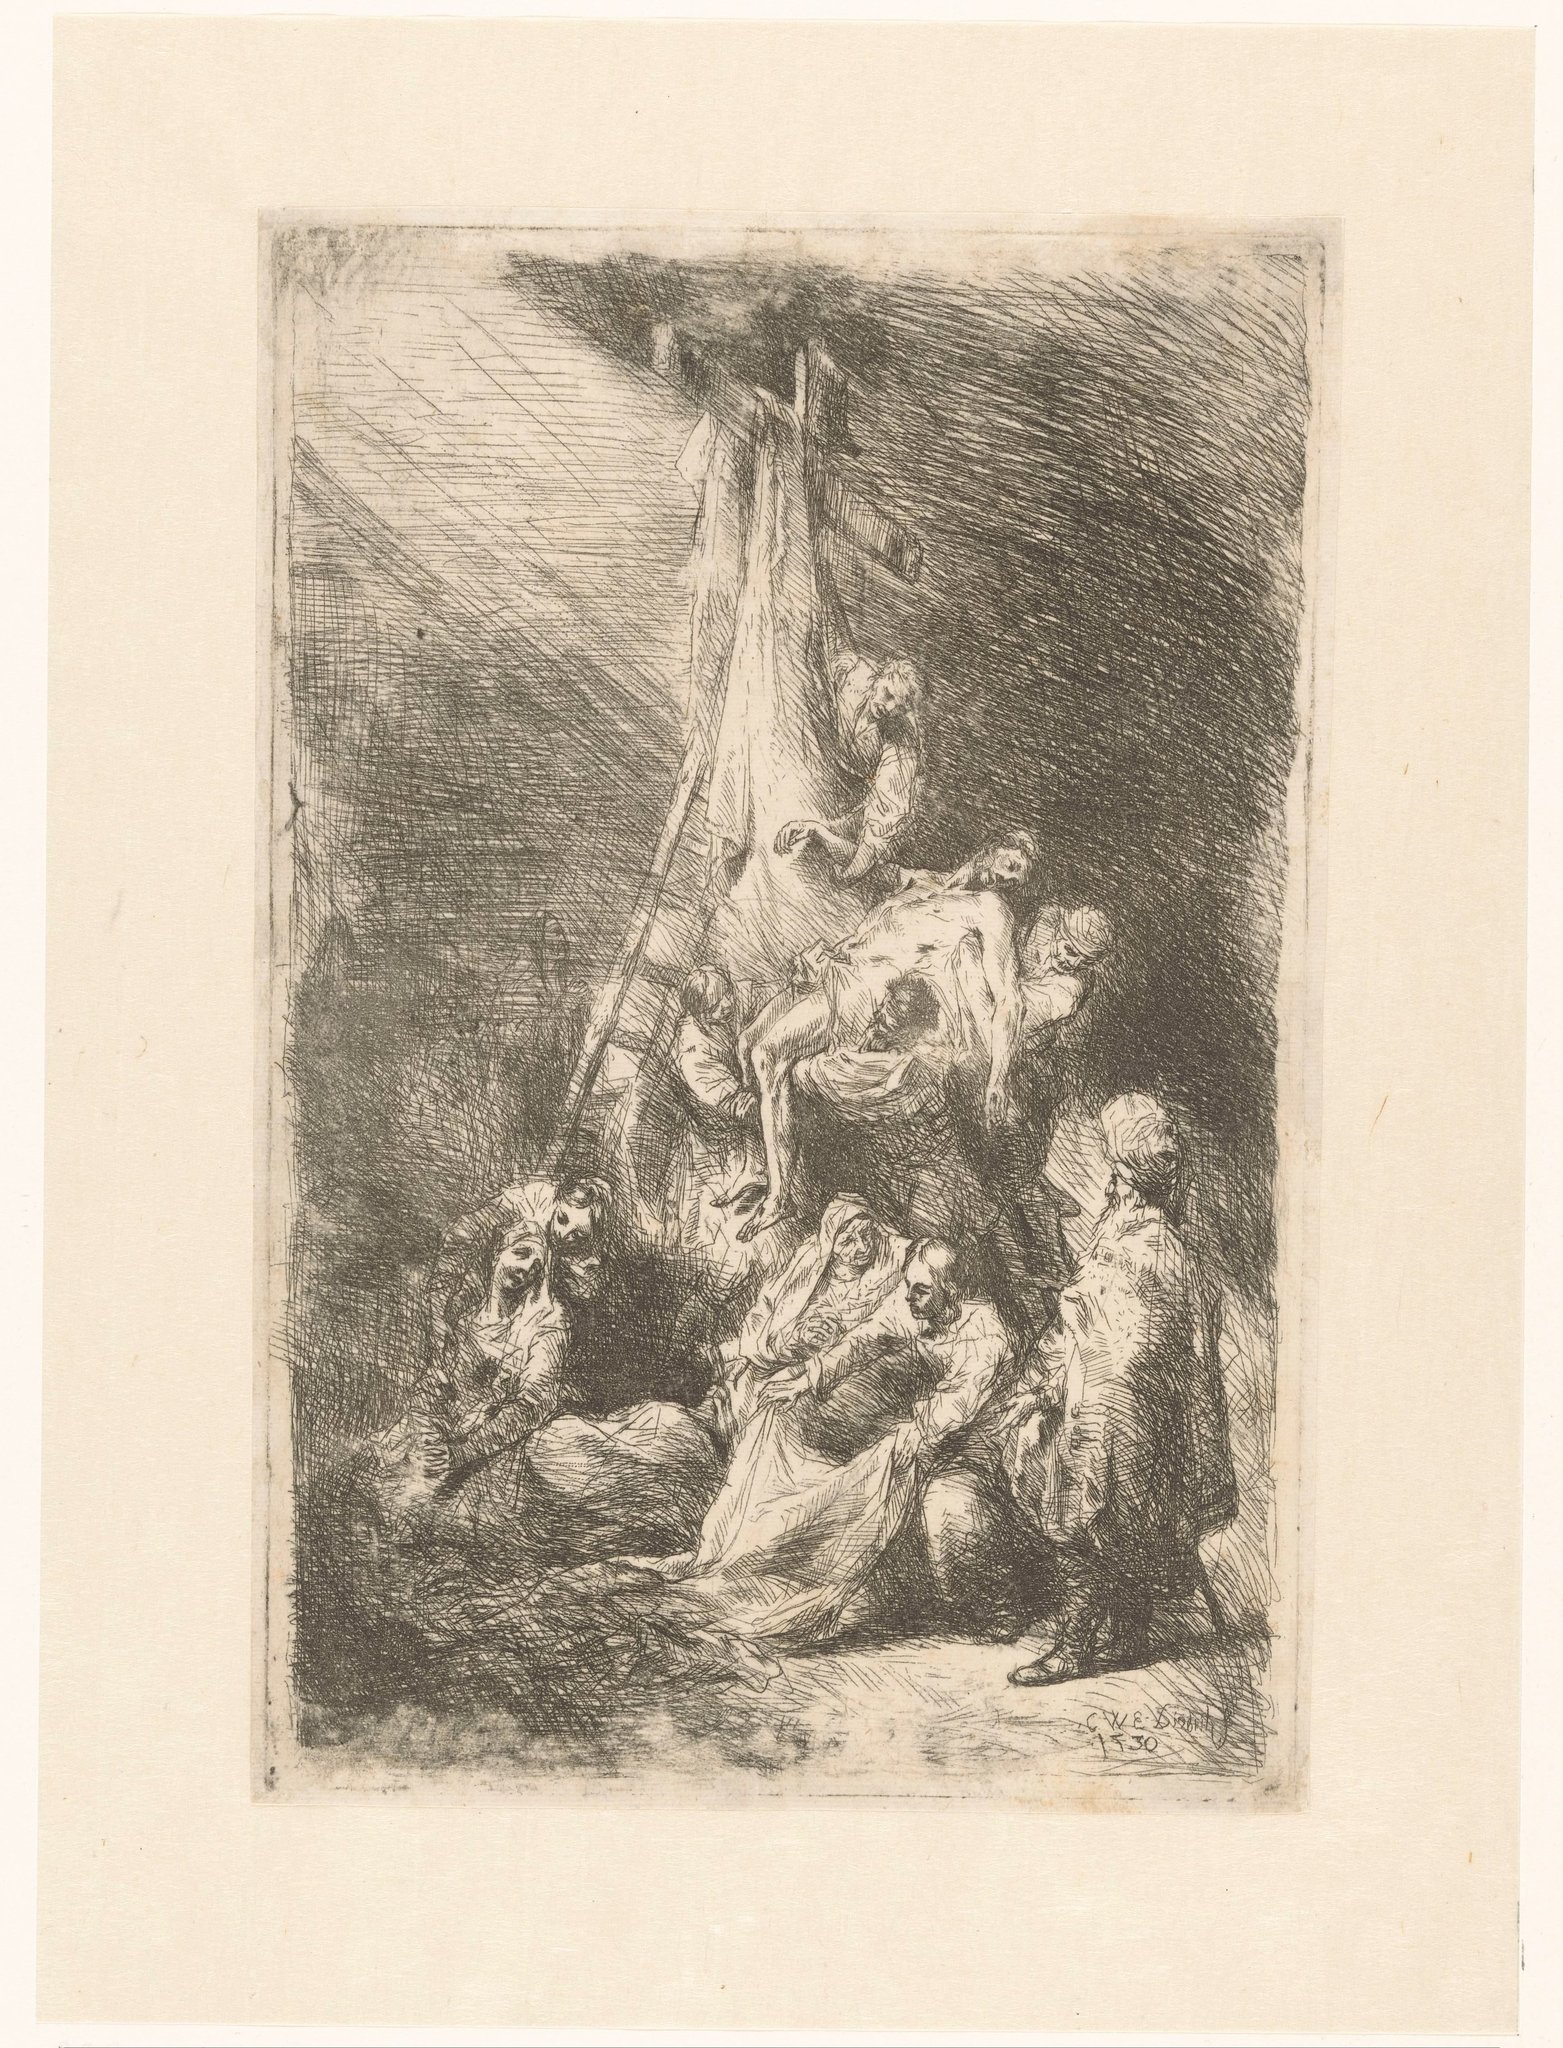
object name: print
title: Kruisafname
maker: christian wilhelm ernst dietrich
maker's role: artist, painter, print maker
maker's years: 1712-1774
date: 1730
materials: paper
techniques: etching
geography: germany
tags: descent from the cross: christ is taken down from the cross, usually by nicodemus and joseph of arimathaea who are standing on the ladders (both arms of christ detached)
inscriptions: collector's mark: Lugt 2228, collector's mark: Lugt 2760